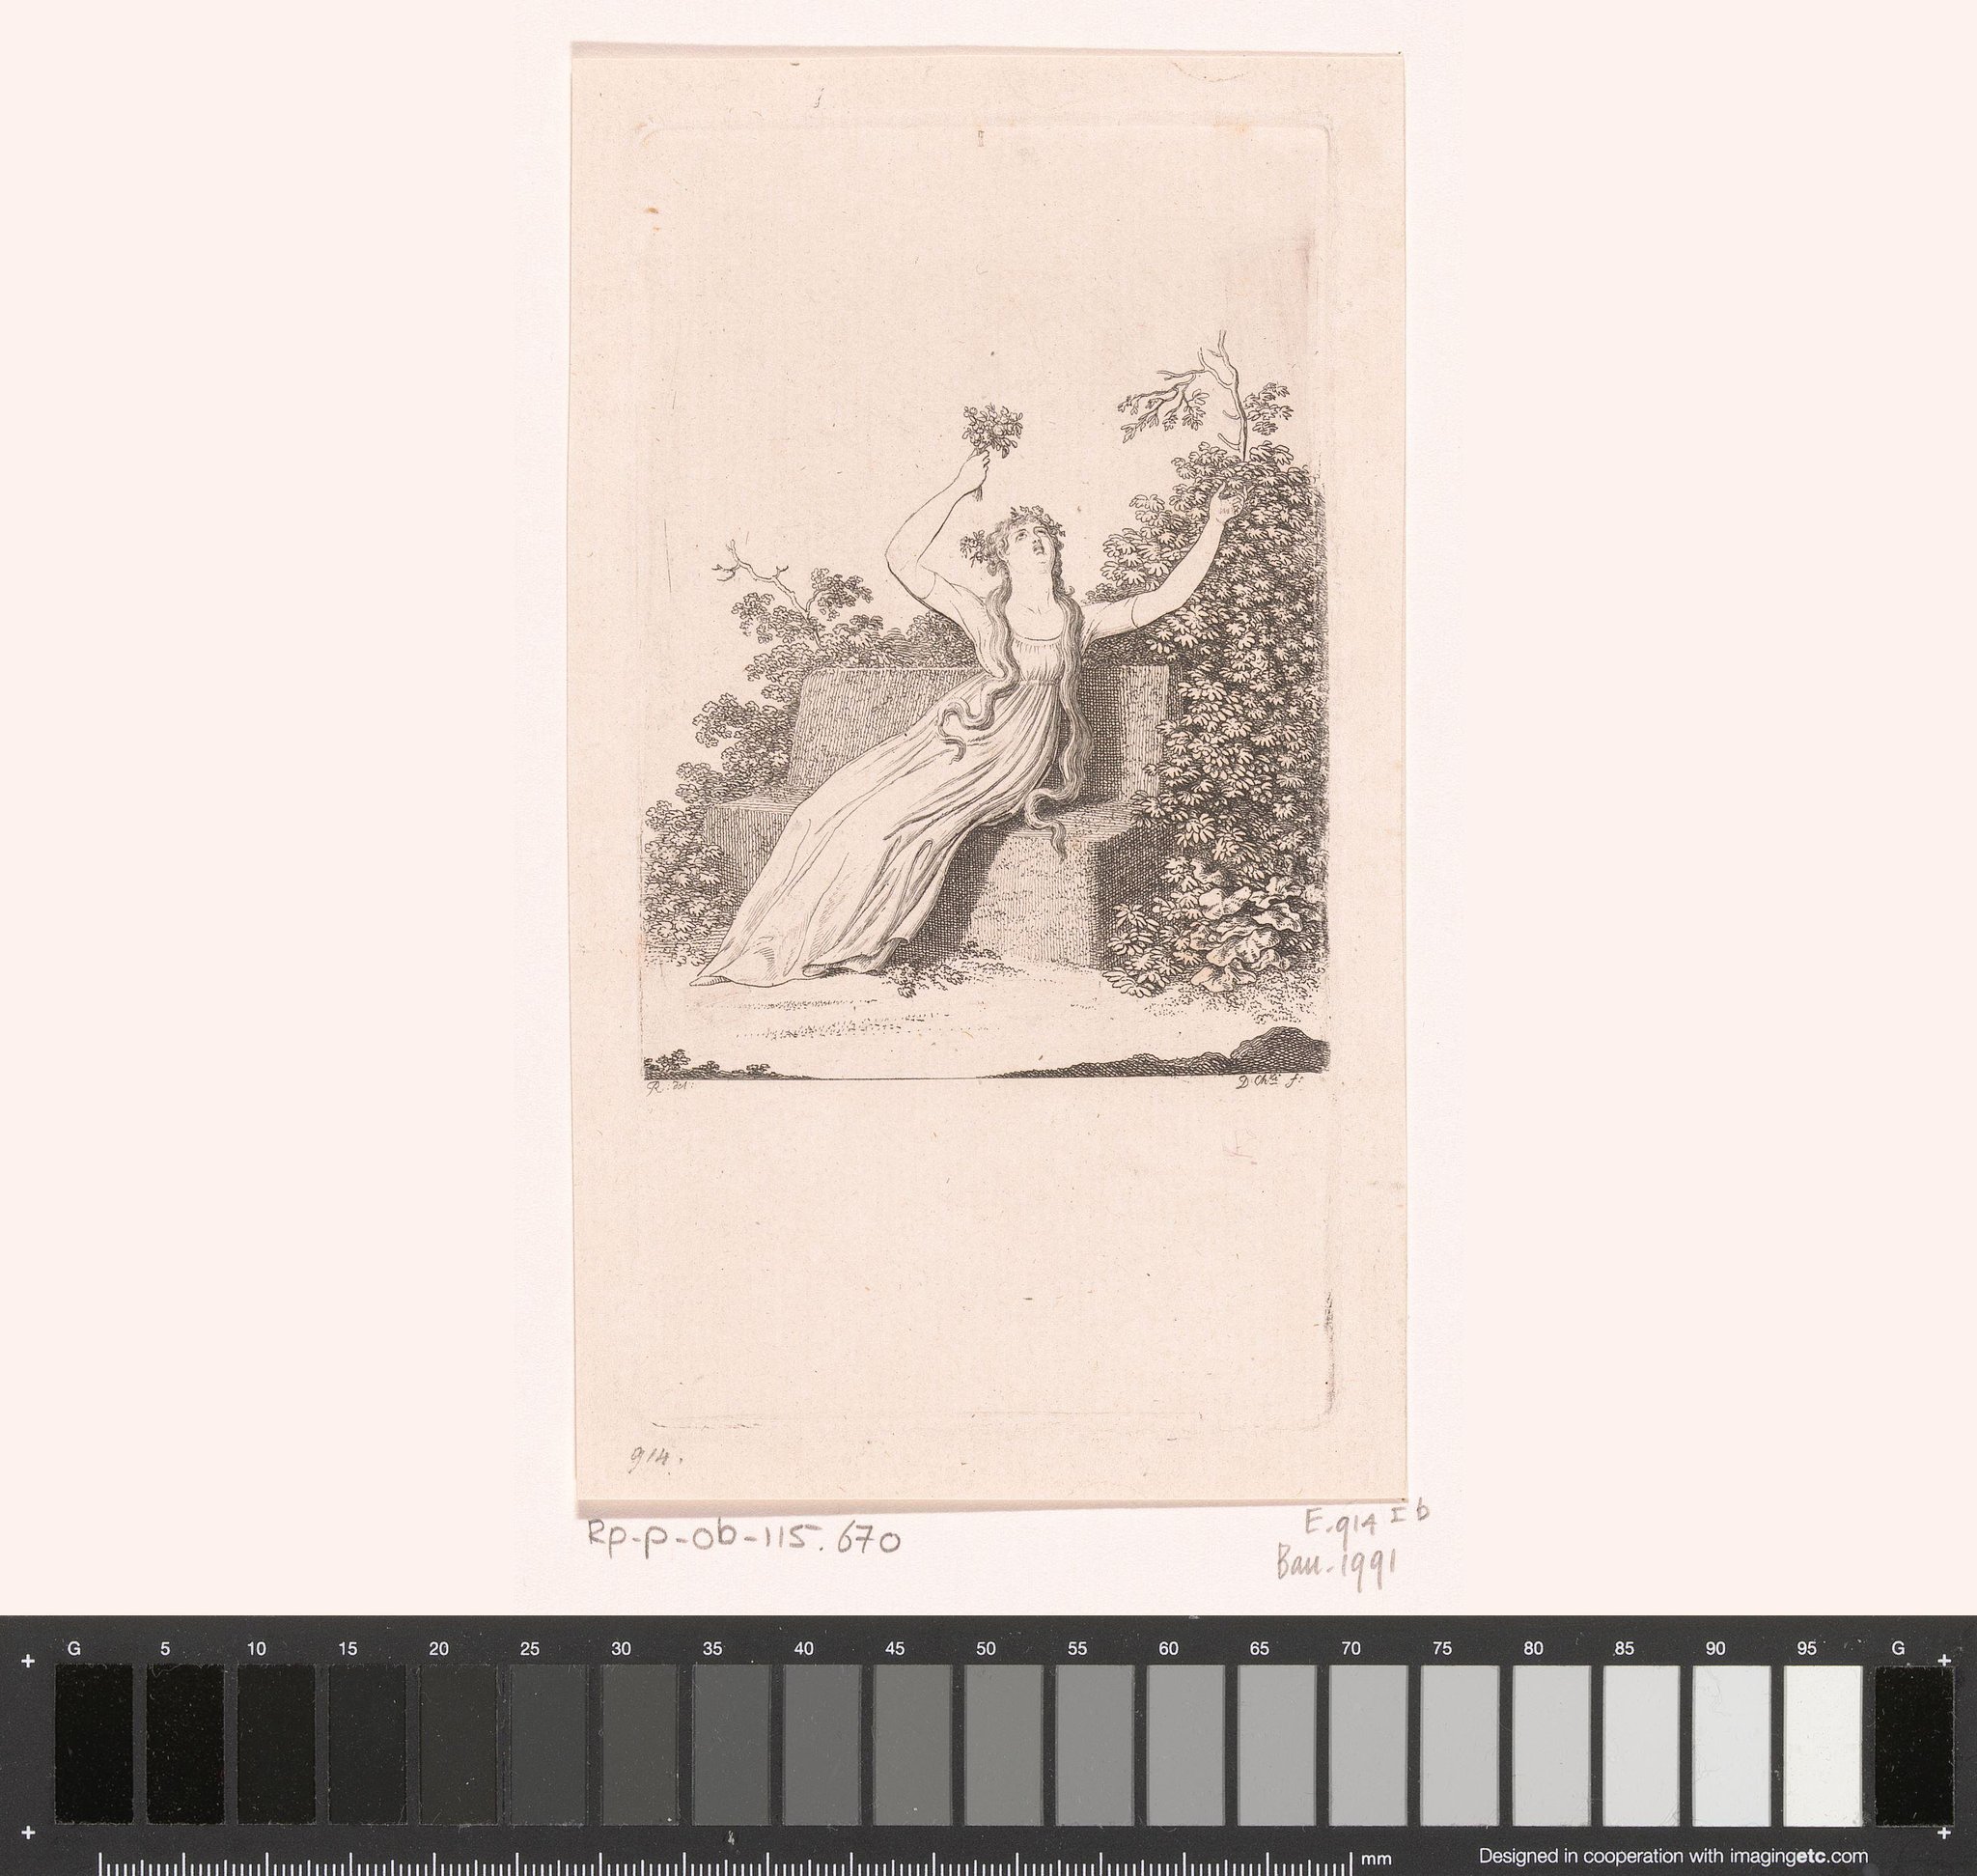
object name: print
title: Nina heft haar handen in wanhoop tot de hemel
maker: daniel nikolaus chodowiecki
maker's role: draughtsman, print maker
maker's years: 1726-1801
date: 1799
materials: paper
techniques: etching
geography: berlin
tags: berlin, bench, cut flowers; nosegay, bunch of flowers, despair; 'disperatione' (ripa)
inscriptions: collector's mark: Lugt 2228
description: Prent gebruikt voor: Rhode, Johann Gottlieb. Berlin, eine Zeitschrift für Freunde der schöne Künste, des Geschmacks und der Moden (...). Berlijn: Decker, 1799-1800.